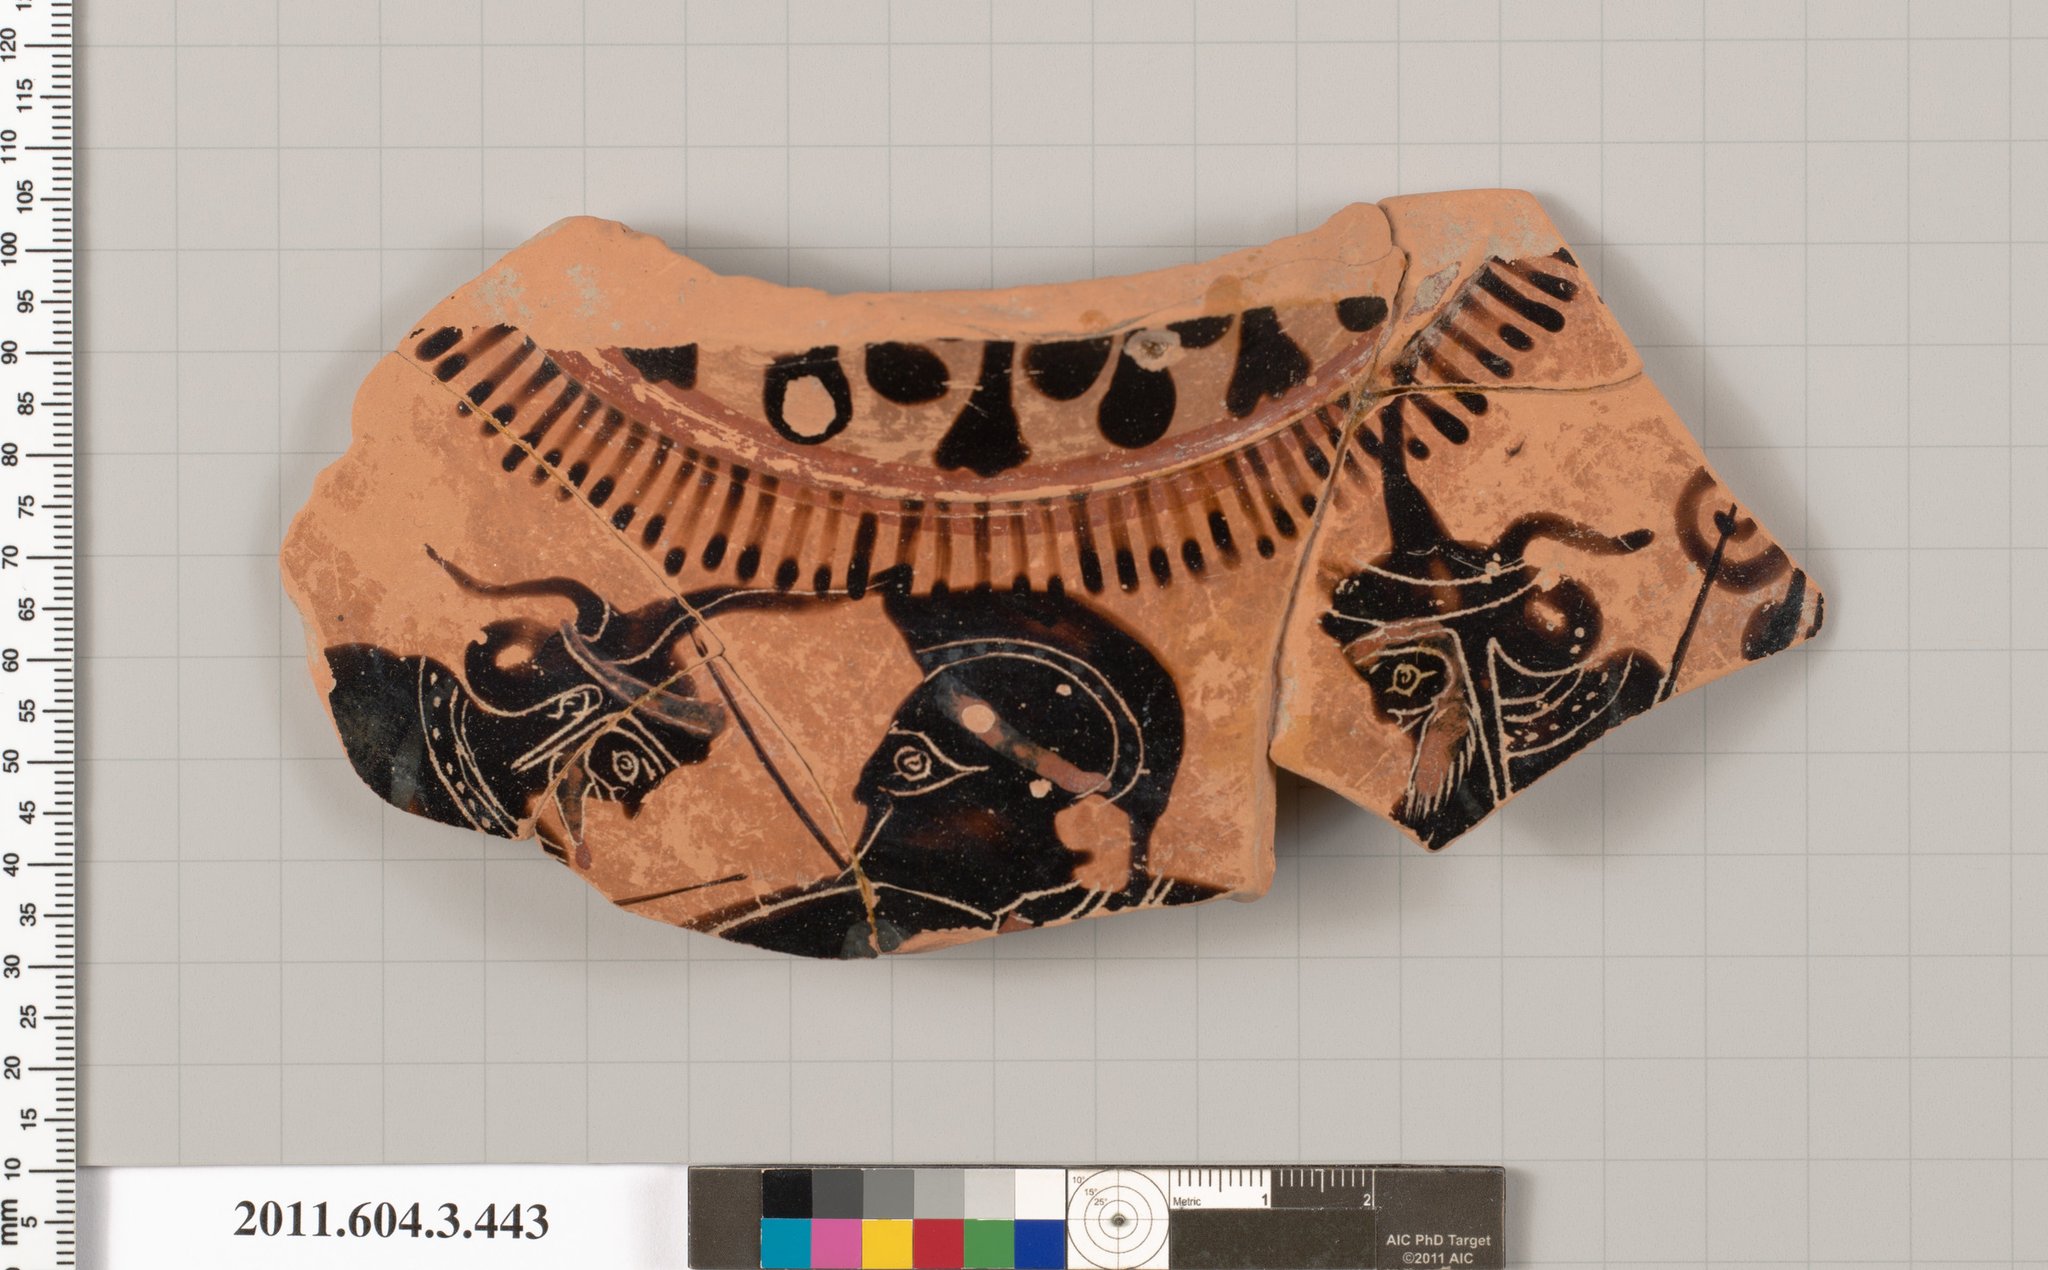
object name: neck amphora fragment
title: Terracotta fragment of a neck-amphora (jar)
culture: greek, attic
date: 500-468 BCE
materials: terracotta